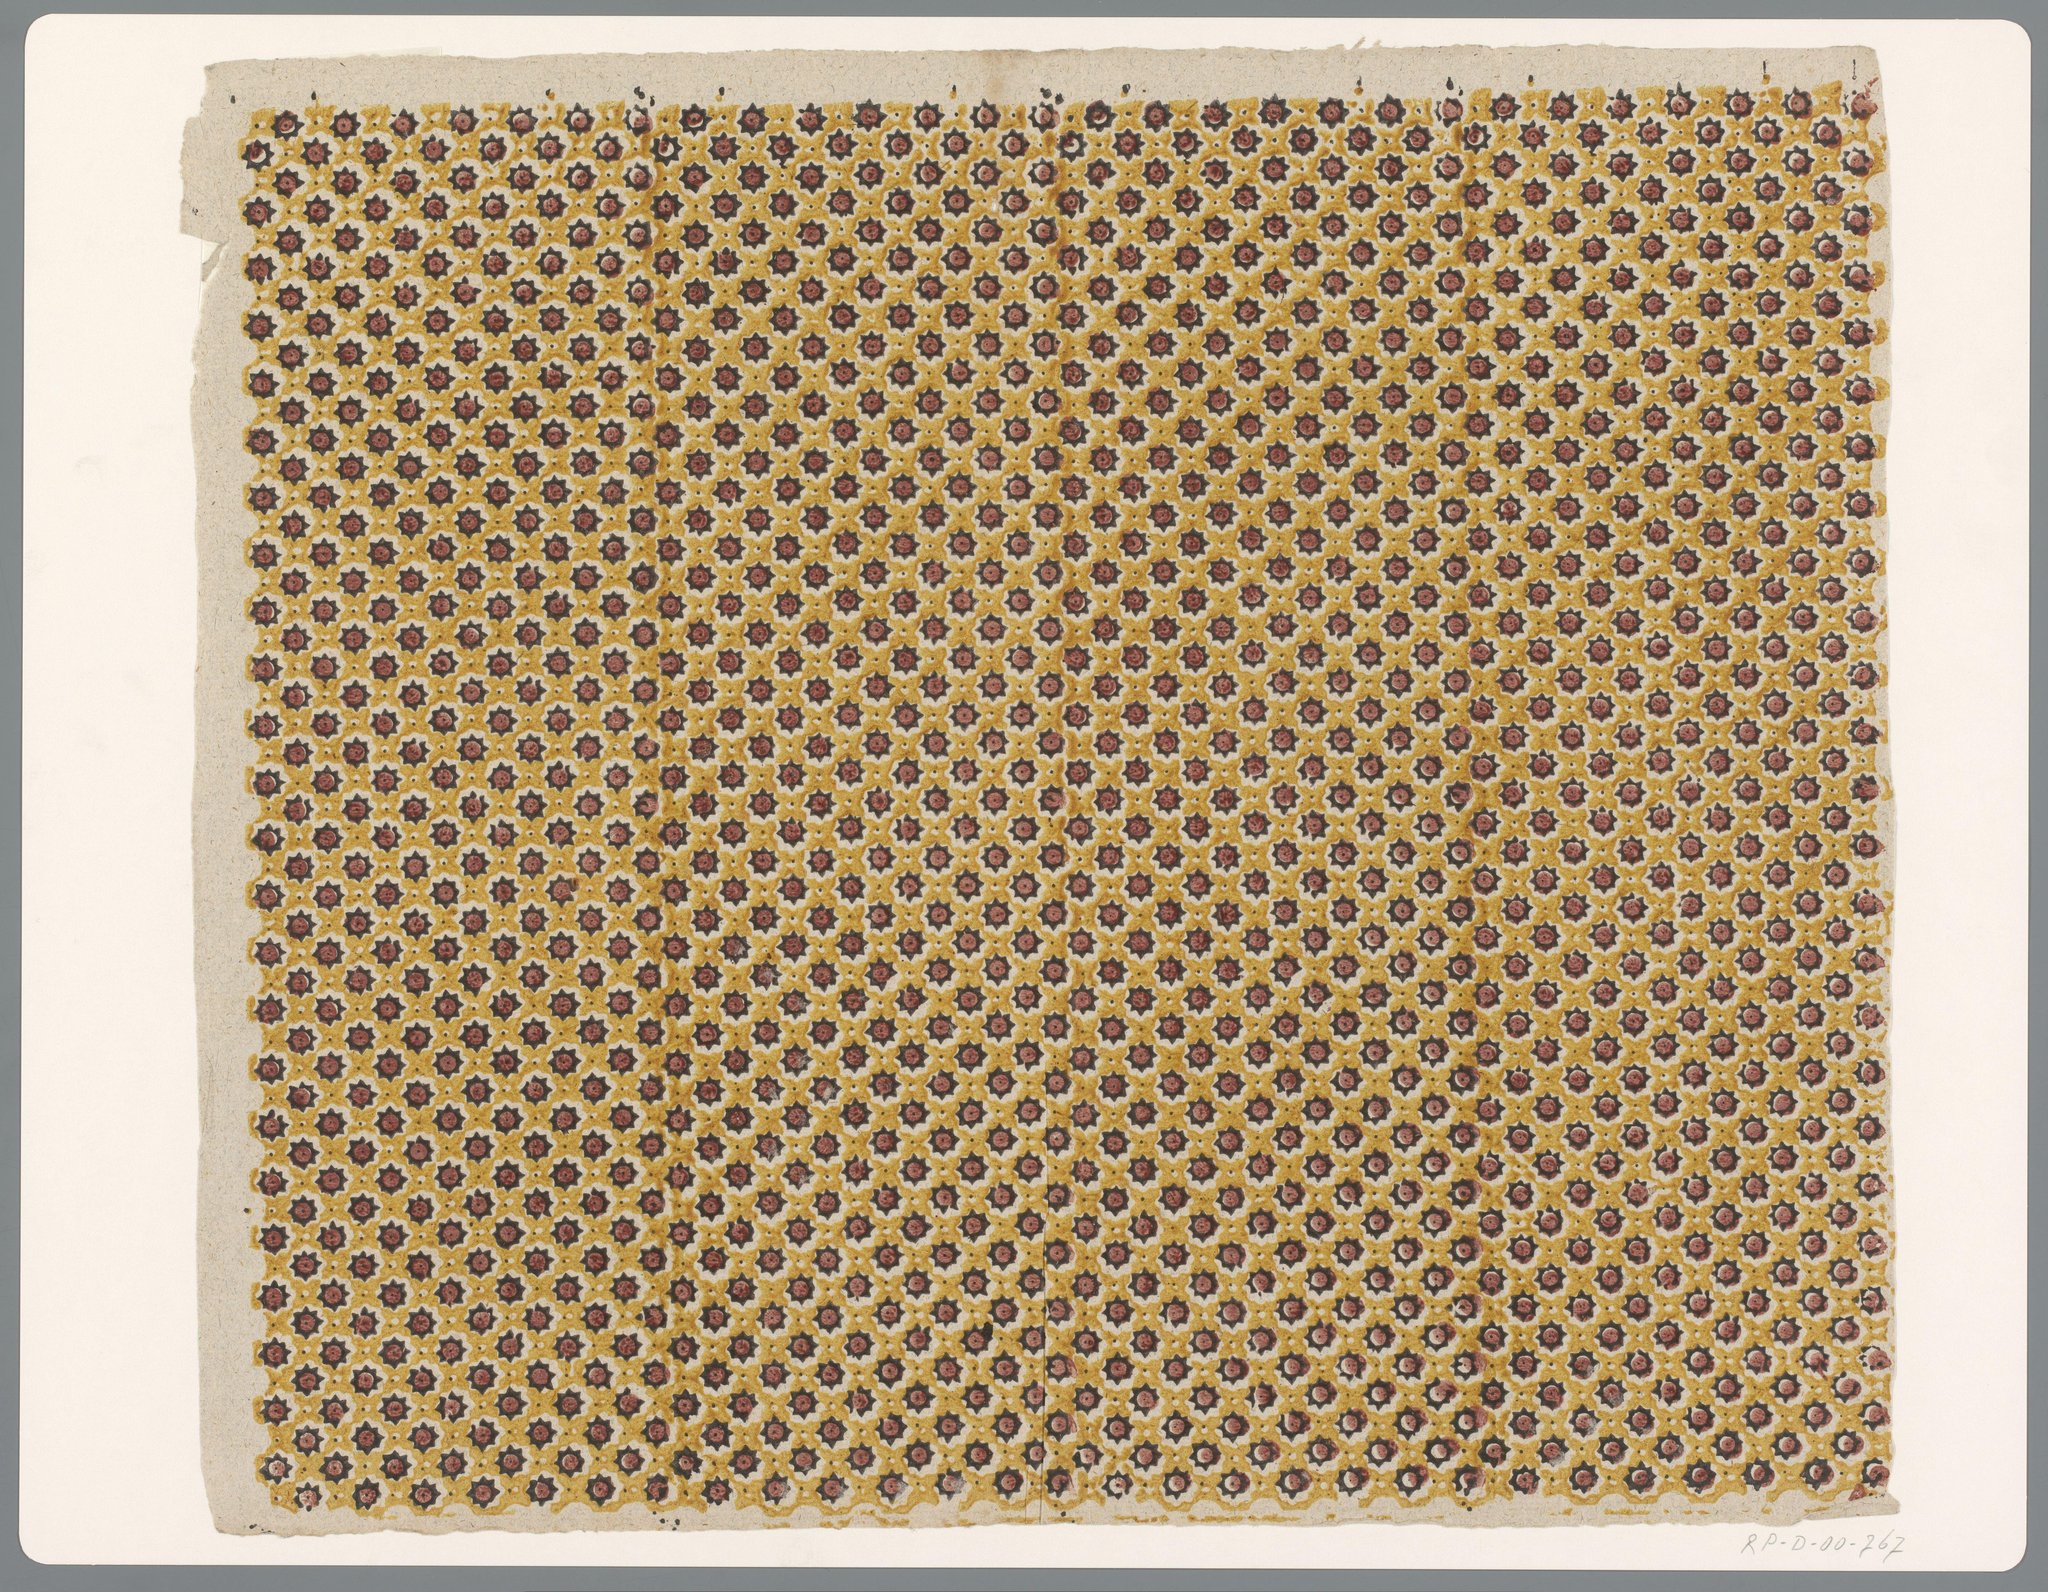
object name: printed paper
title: Blad met strooipatroon van ster- of bloemmotief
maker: Anonymous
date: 1750-1950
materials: lacquer, paper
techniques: printing block, lacquer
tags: ornament derived from plant forms